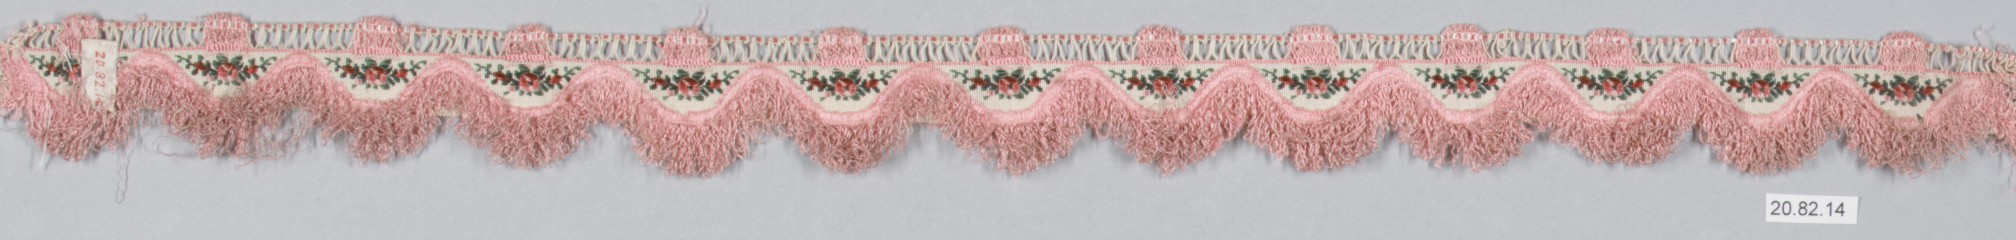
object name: ribbon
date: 1801-1833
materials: silk